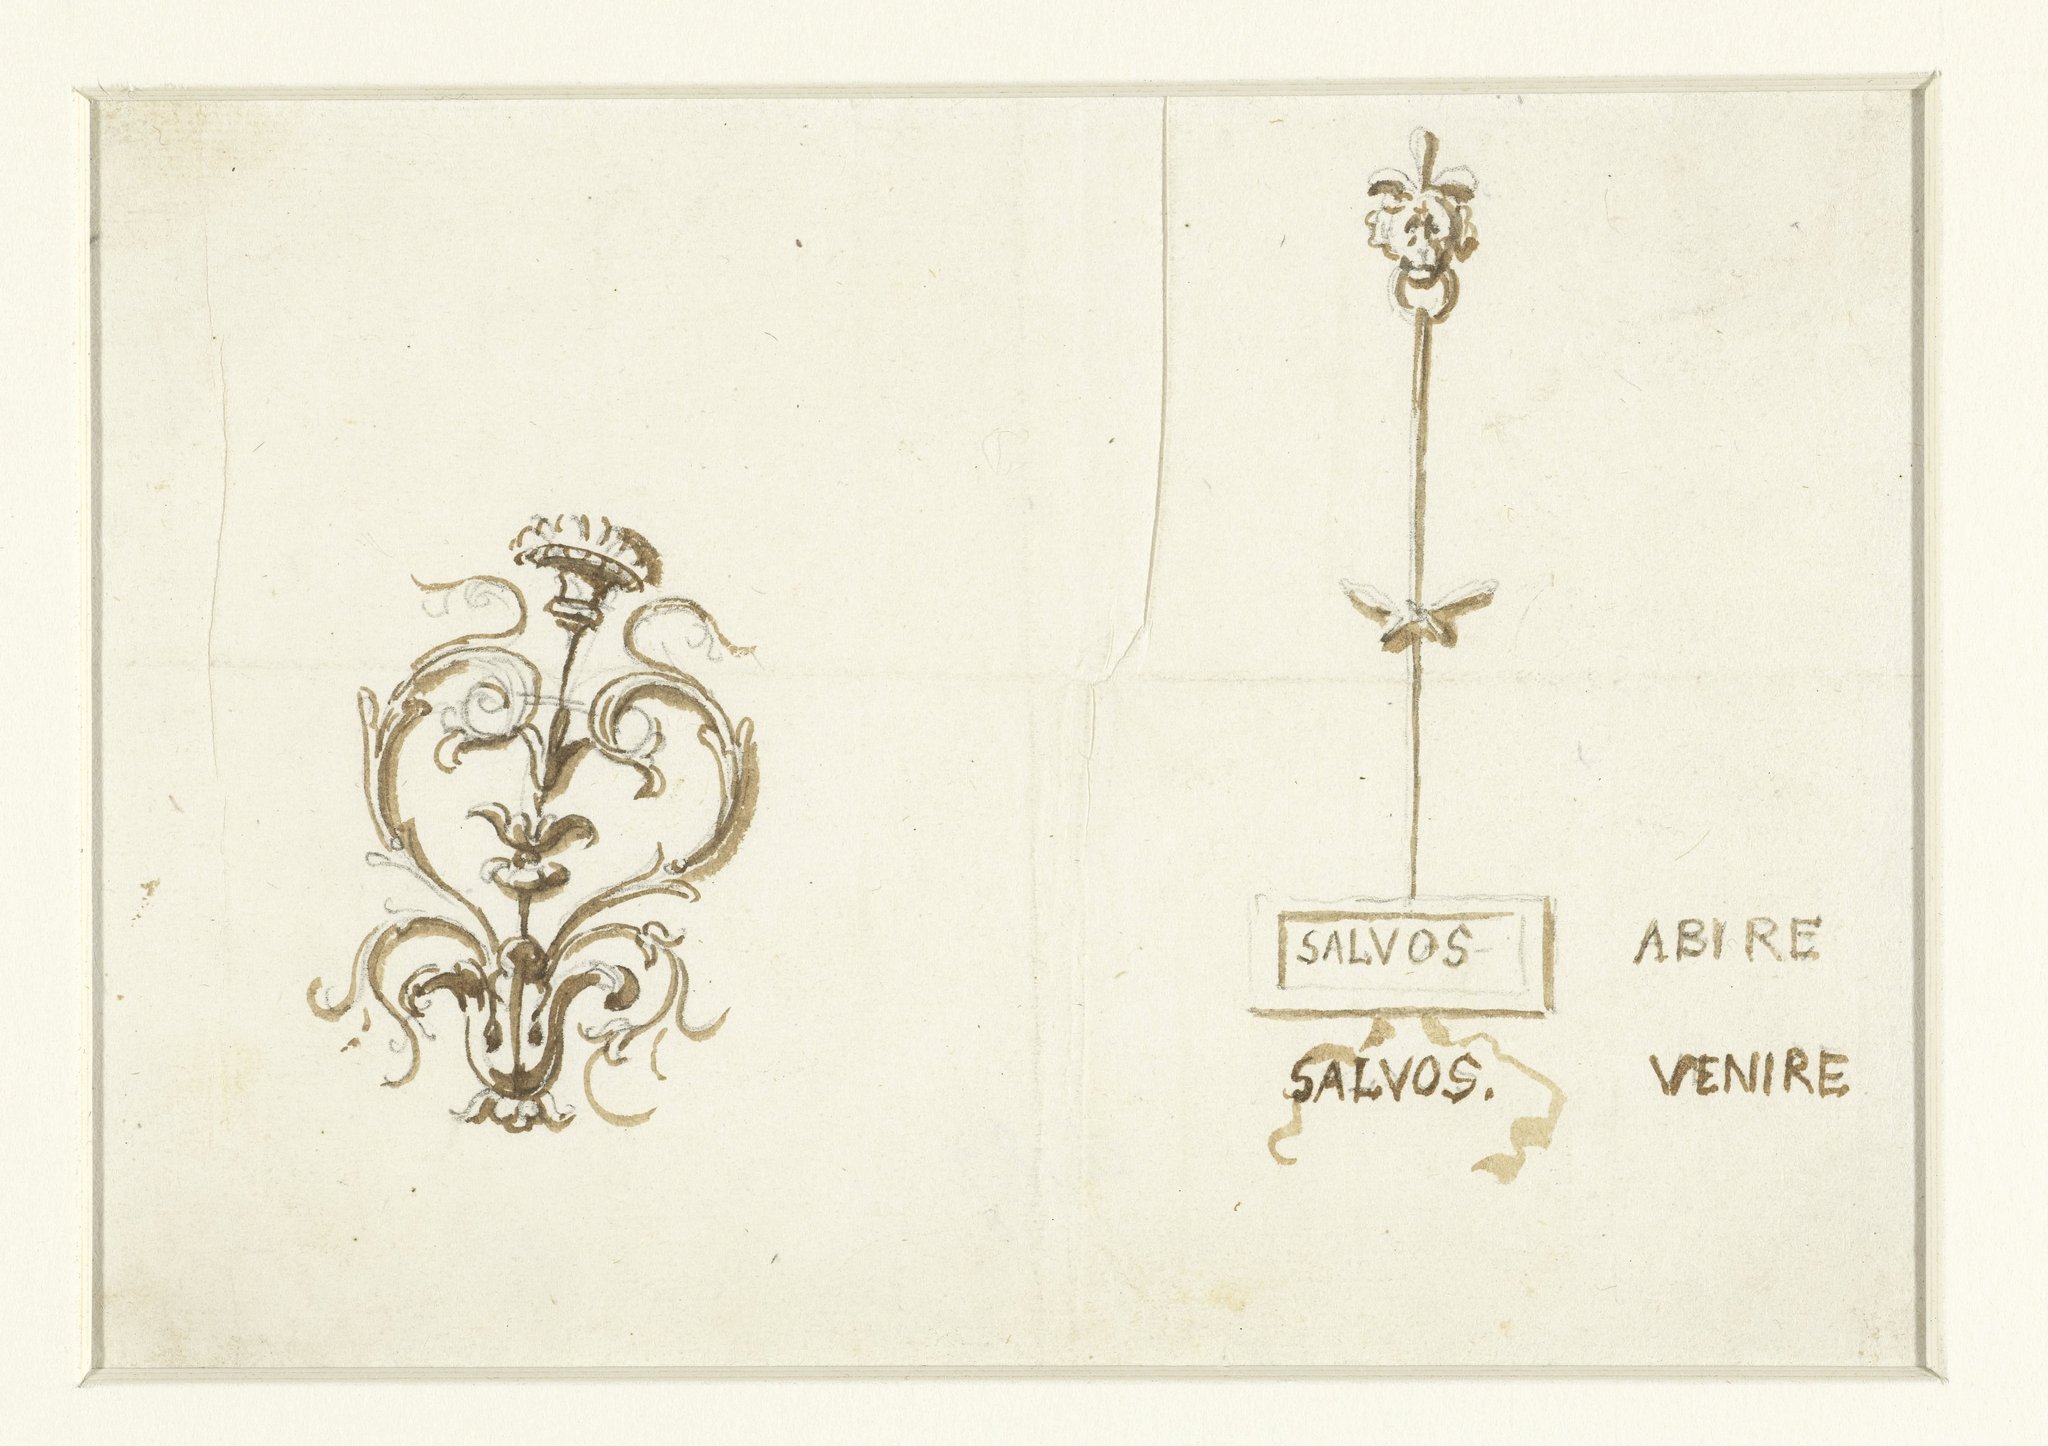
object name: drawing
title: Antiek ornament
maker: etienne de lavallée-poussin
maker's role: draughtsman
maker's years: 1733-1793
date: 1762-1777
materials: ink, paper, pencil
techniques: brush, pen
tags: ornament derived from plant forms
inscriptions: collector's mark, verso, on the mount, lower centre: Lugt 2228